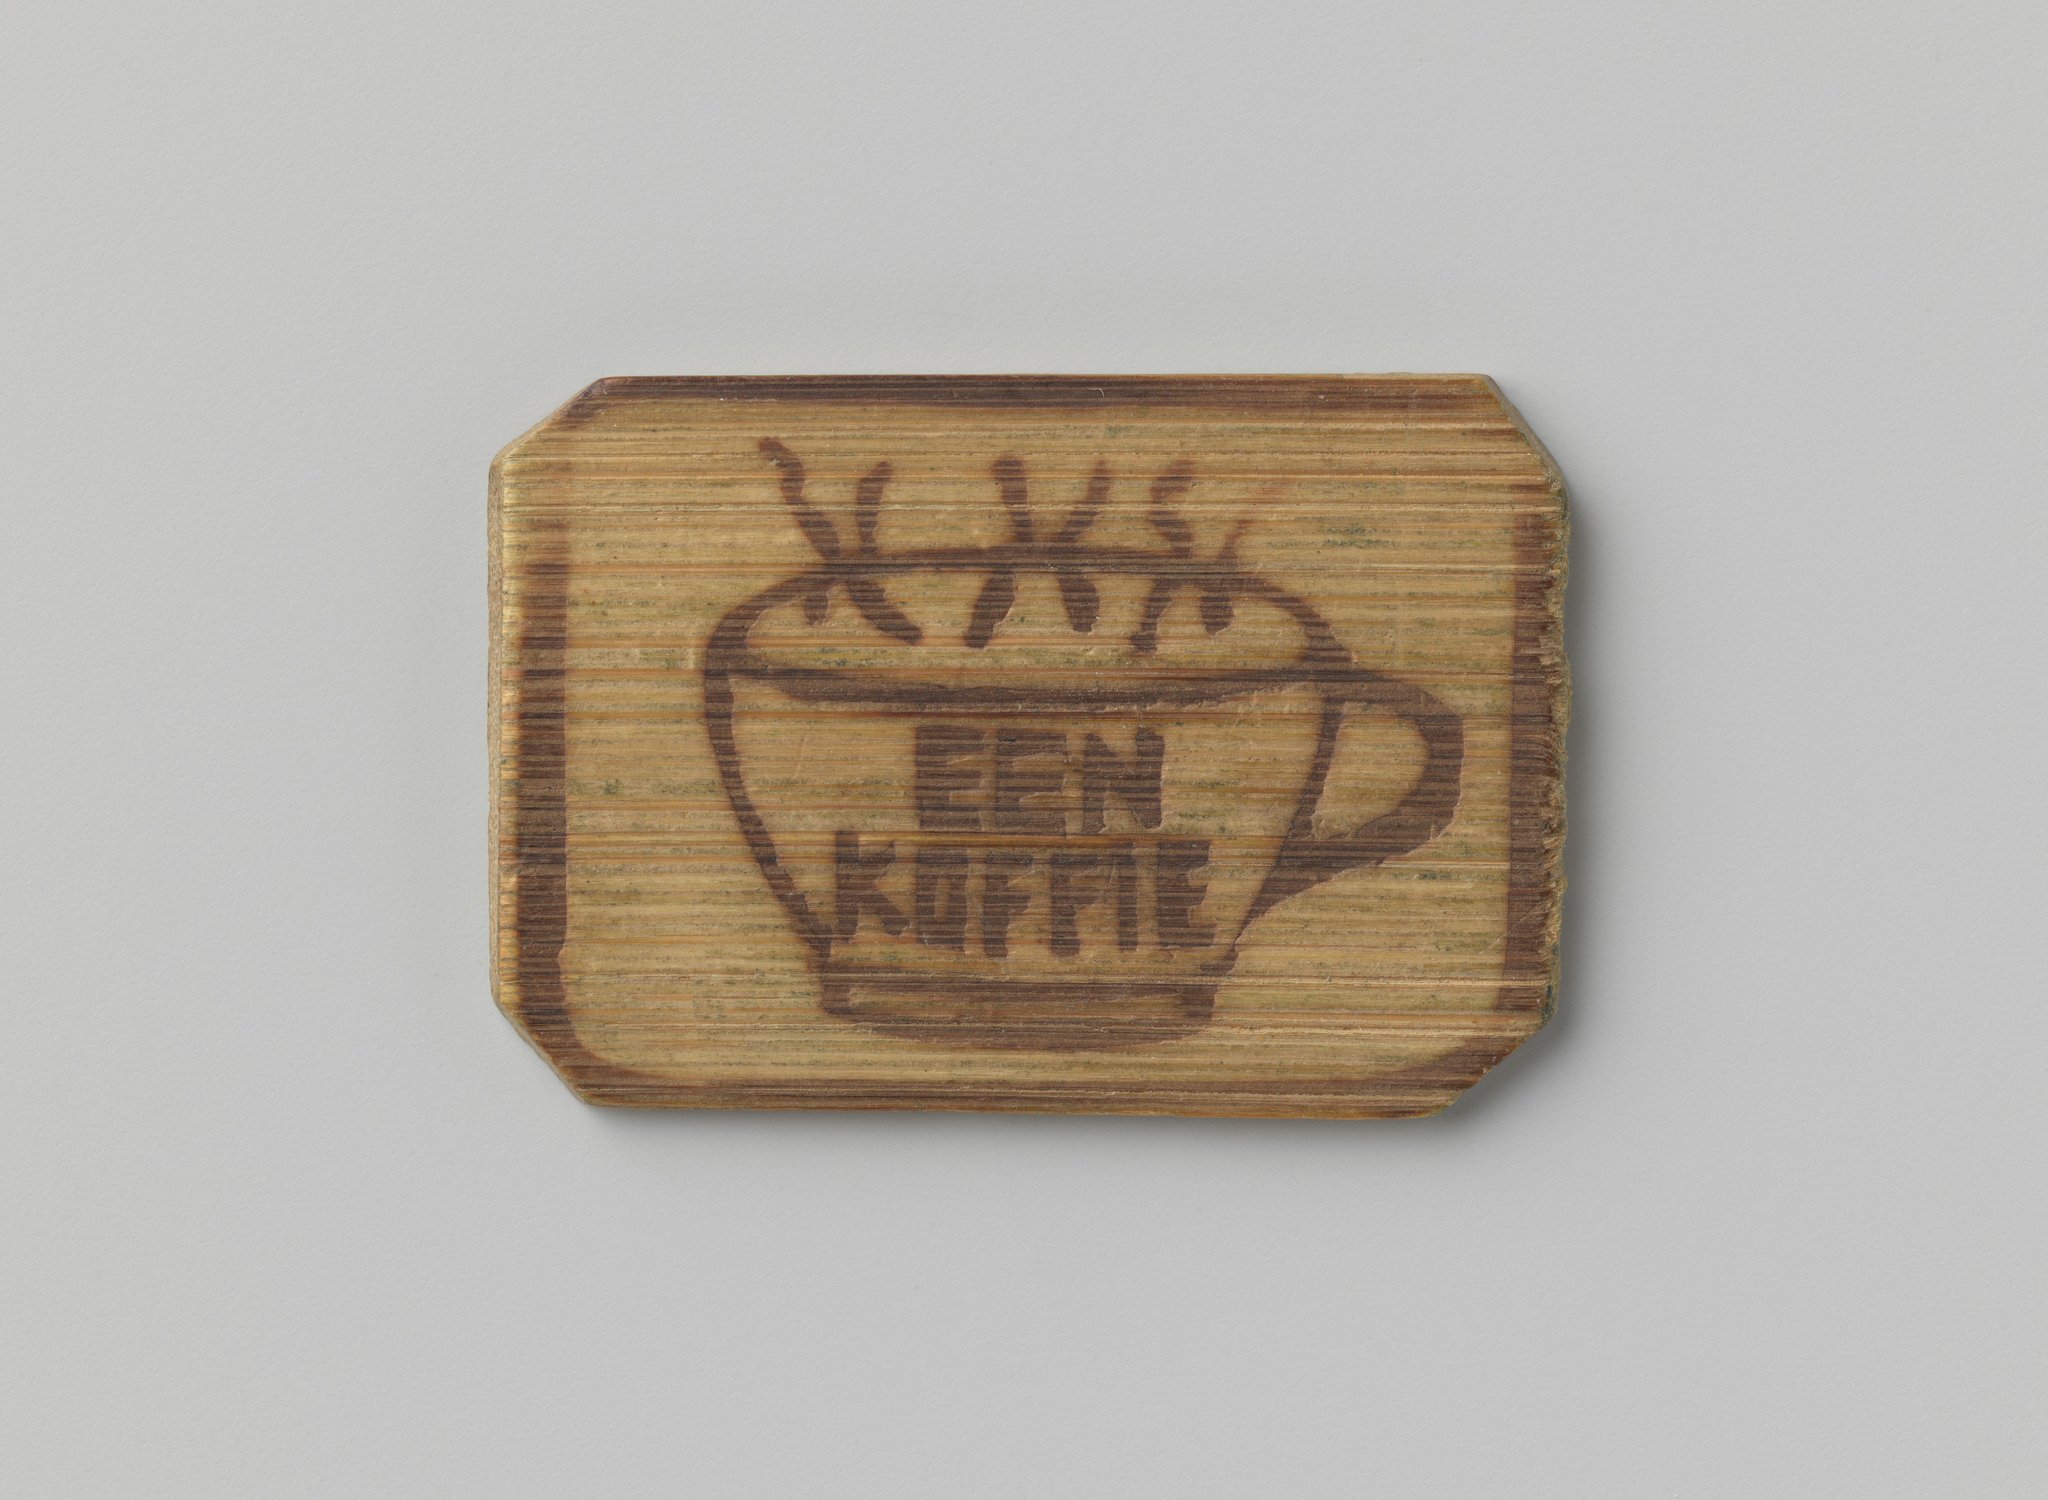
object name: monetary token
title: Betaalpenning (kamptoken) voor één koffie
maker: Anonymous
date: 1943-1945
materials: bamboo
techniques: branding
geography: tjimahi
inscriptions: mark: ‘EEN / KOFFIE’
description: Een plakje bamboe, met daarop het bandmerk van een dampende kop koffie met opschrift EEN / KOFFIE. Volgens de overlevering werd de penning gebruikt in het kamp Baros 5 bij Tjimahi (West-Java).